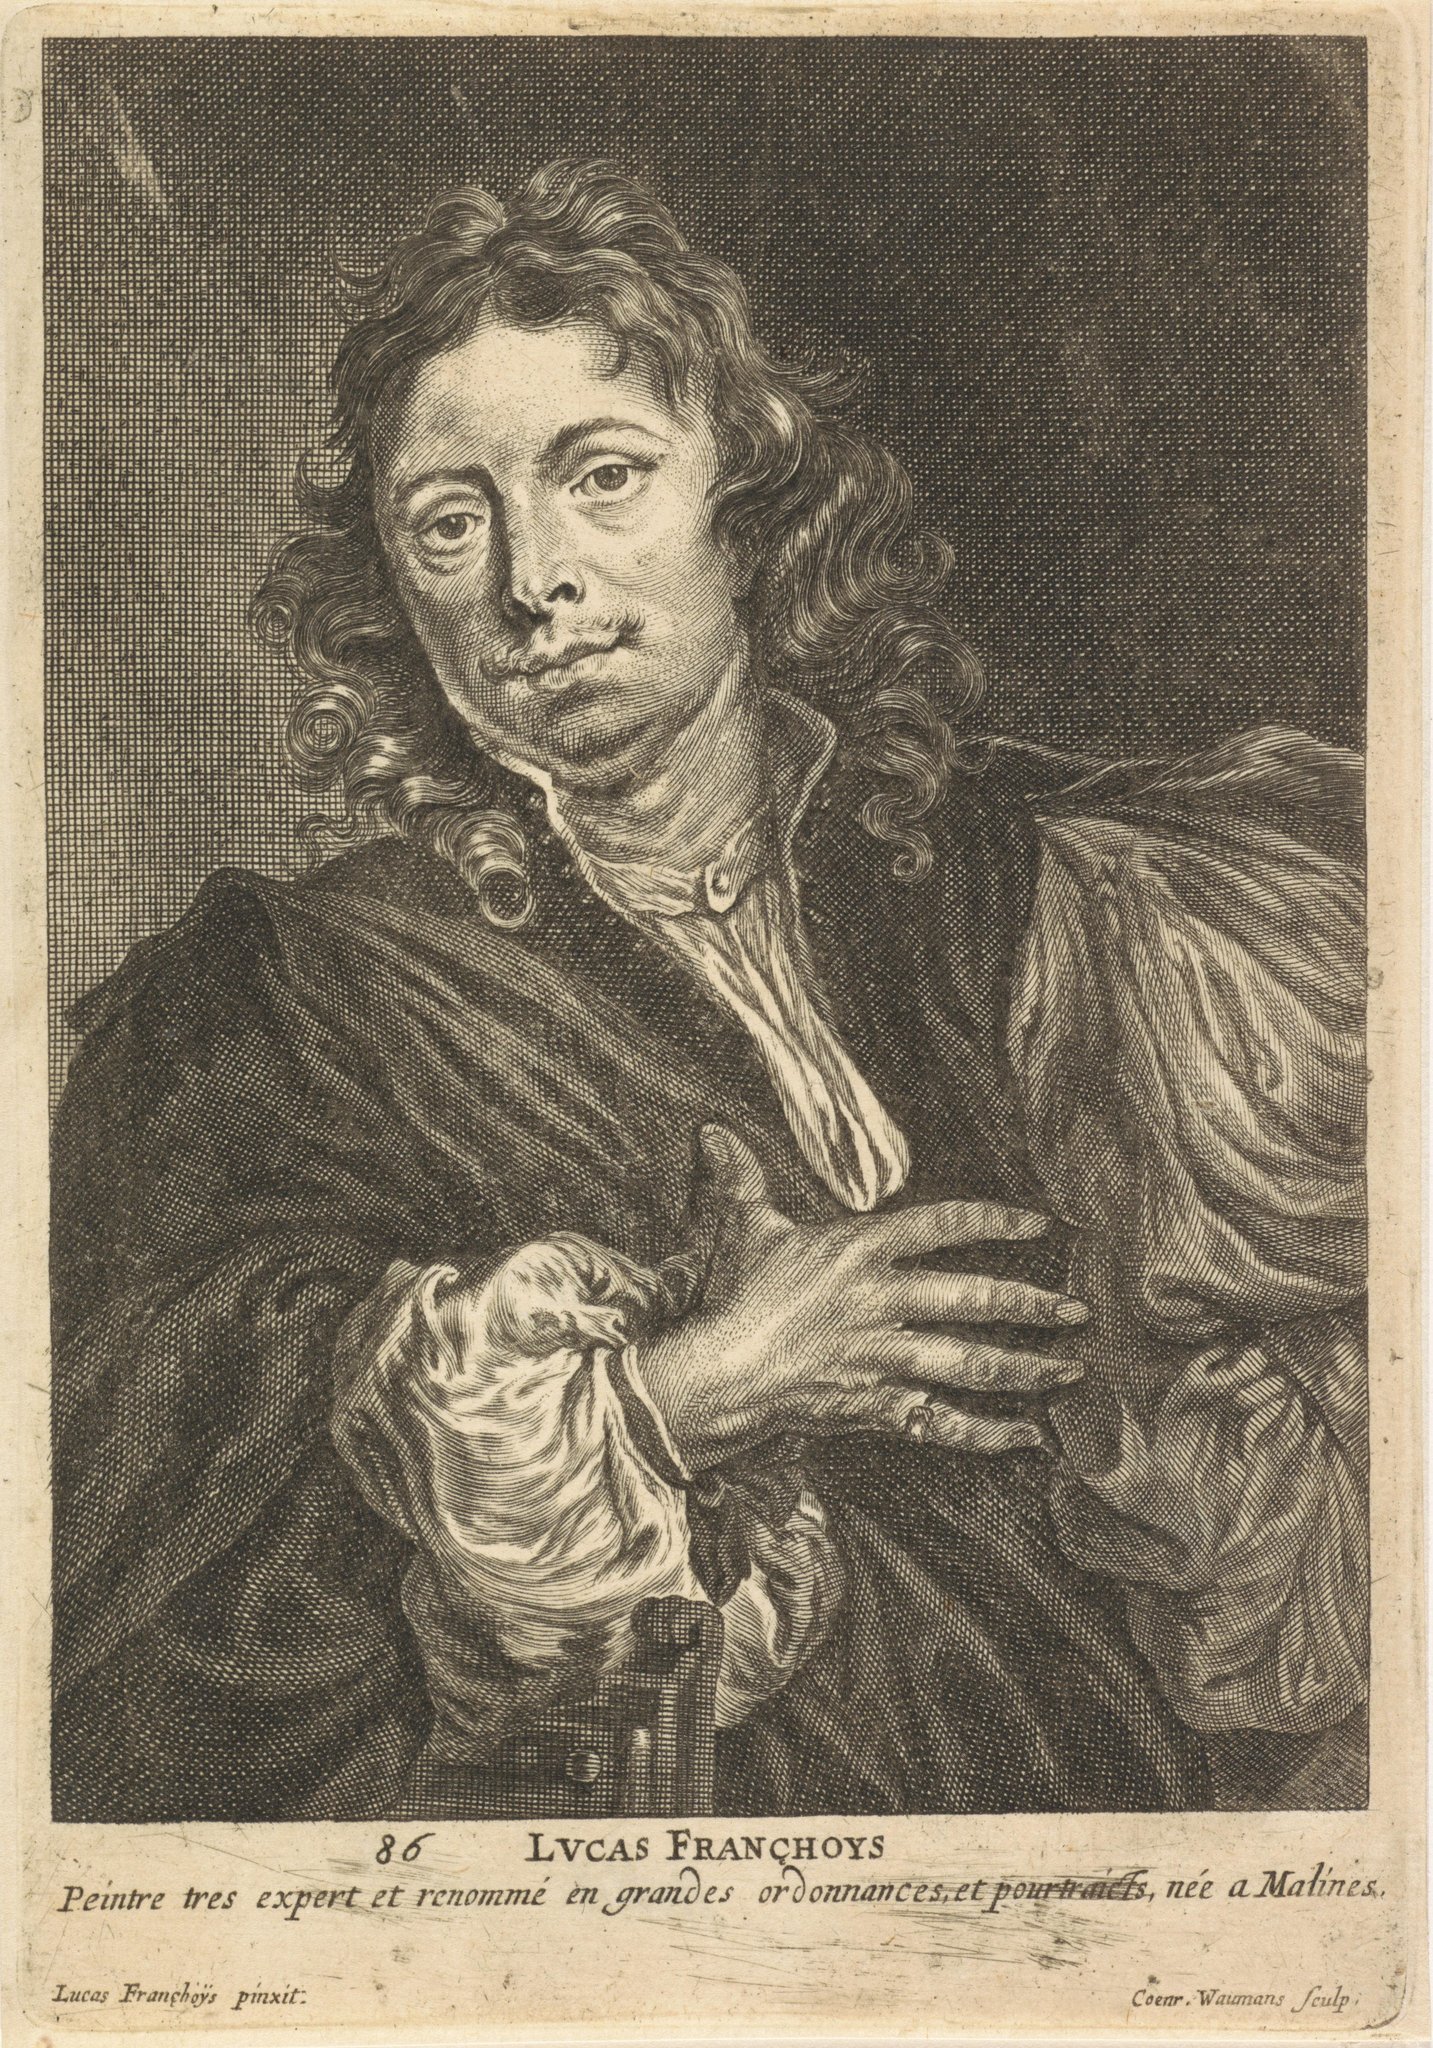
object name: print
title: Portret van de schilder Lucas Franchoys (II)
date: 1694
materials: paper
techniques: engraving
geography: antwerp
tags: print maker, lucas franchoys (ii), portrait, self-portrait of painter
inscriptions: collector's mark: Lugt 2228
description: Prent gebruikt in: The true effigies of the most emminent painters and other famous artists that have flourished in Europe curiously engraven on 125 copper plates. Antwerpen: J. Meyssens, 1694.